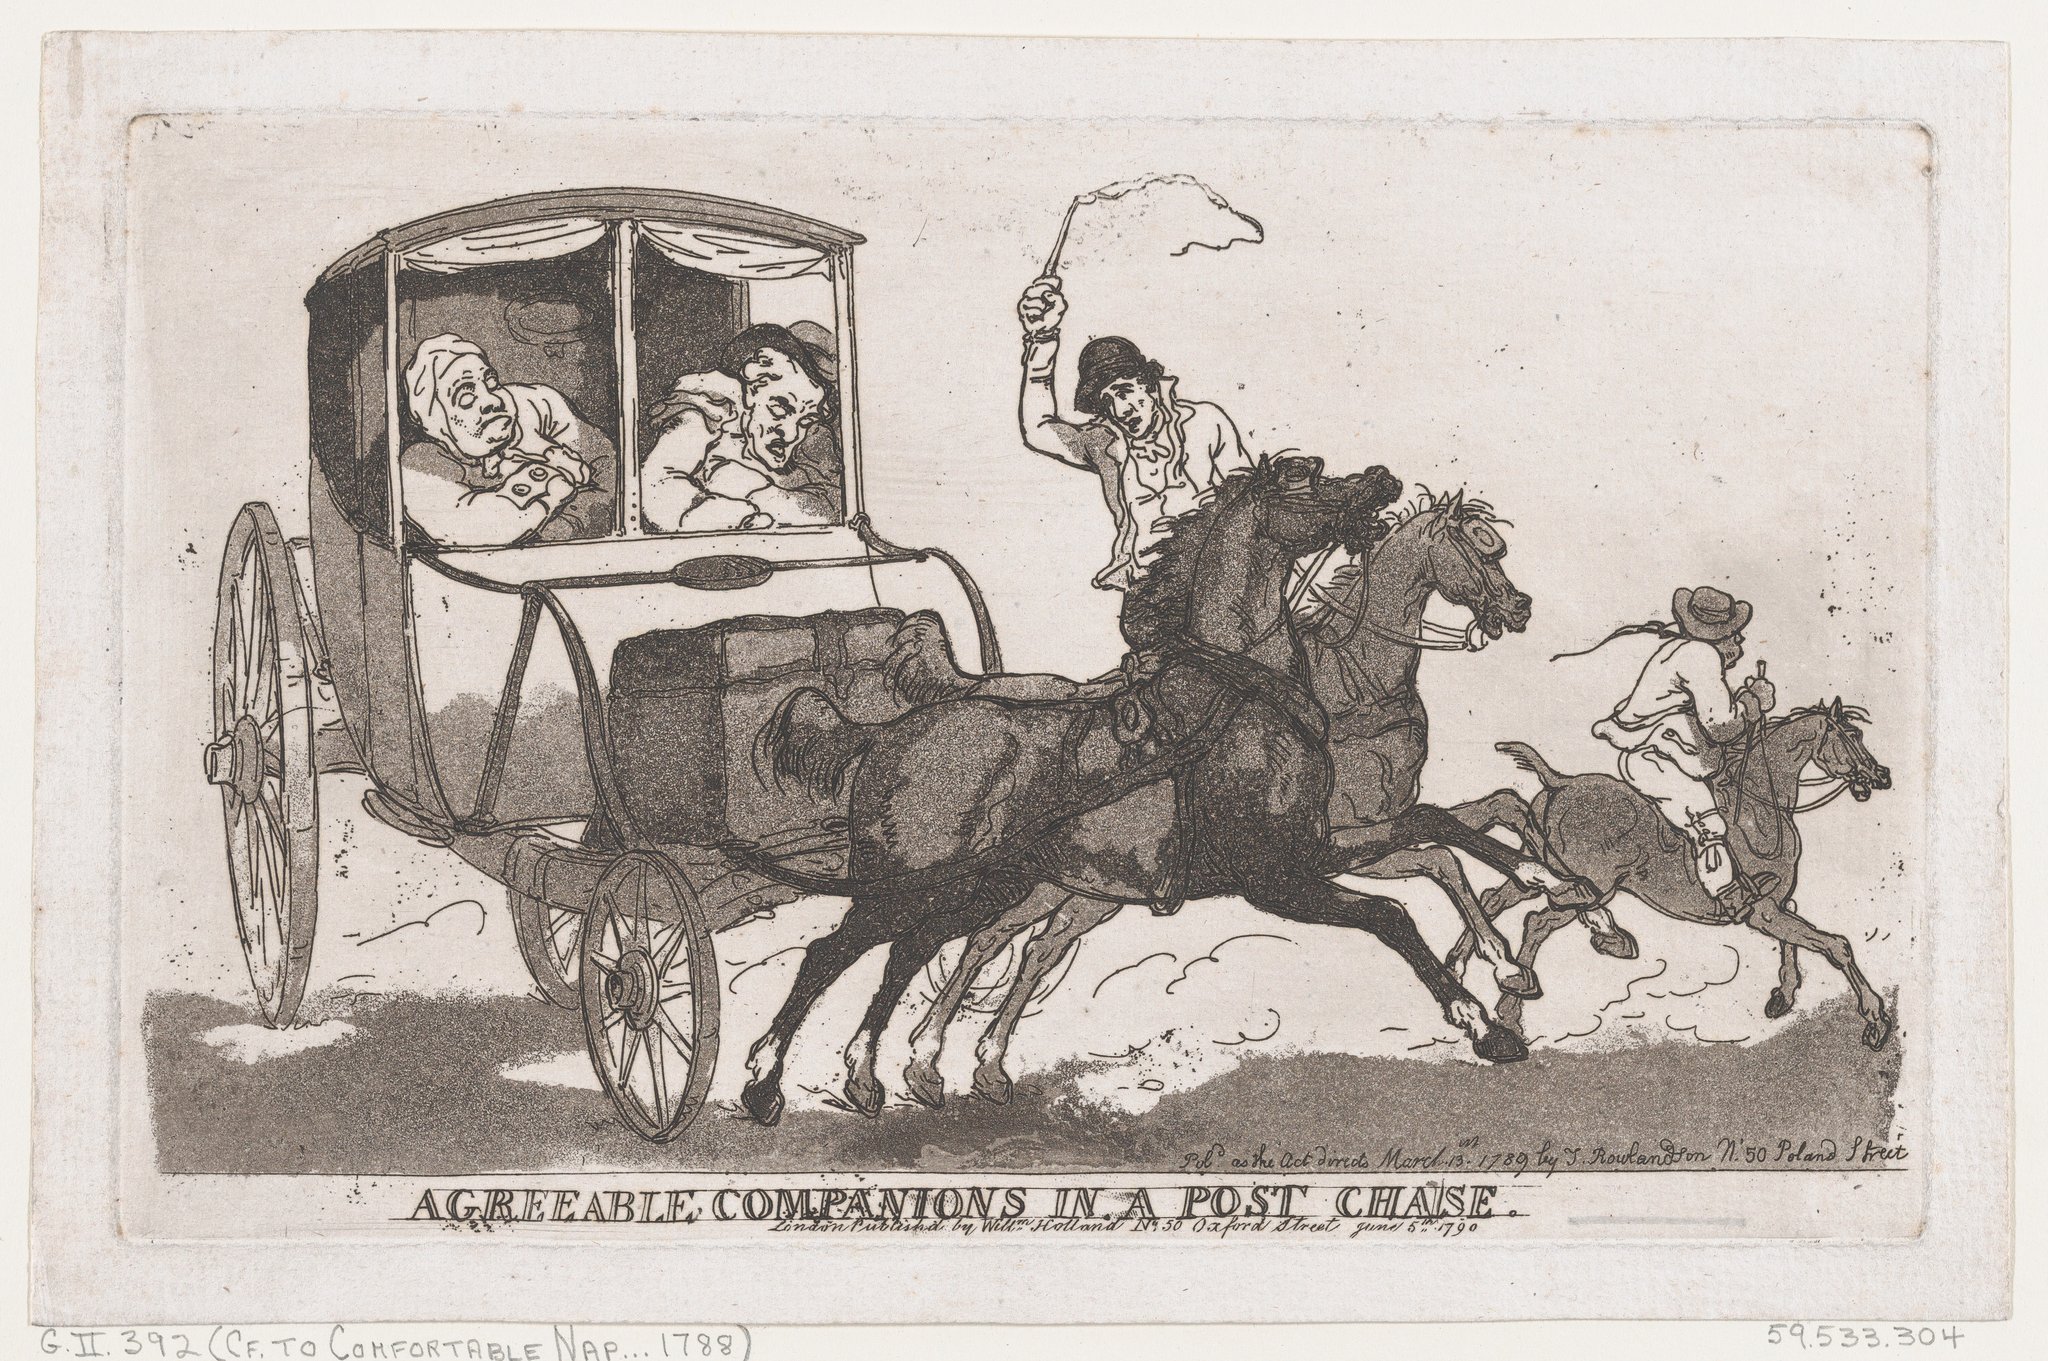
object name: print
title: Agreeable Companions in a Post Chaise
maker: thomas rowlandson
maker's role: artist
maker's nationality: british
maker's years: 1757-1827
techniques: aquatint, etching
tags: men,carriages